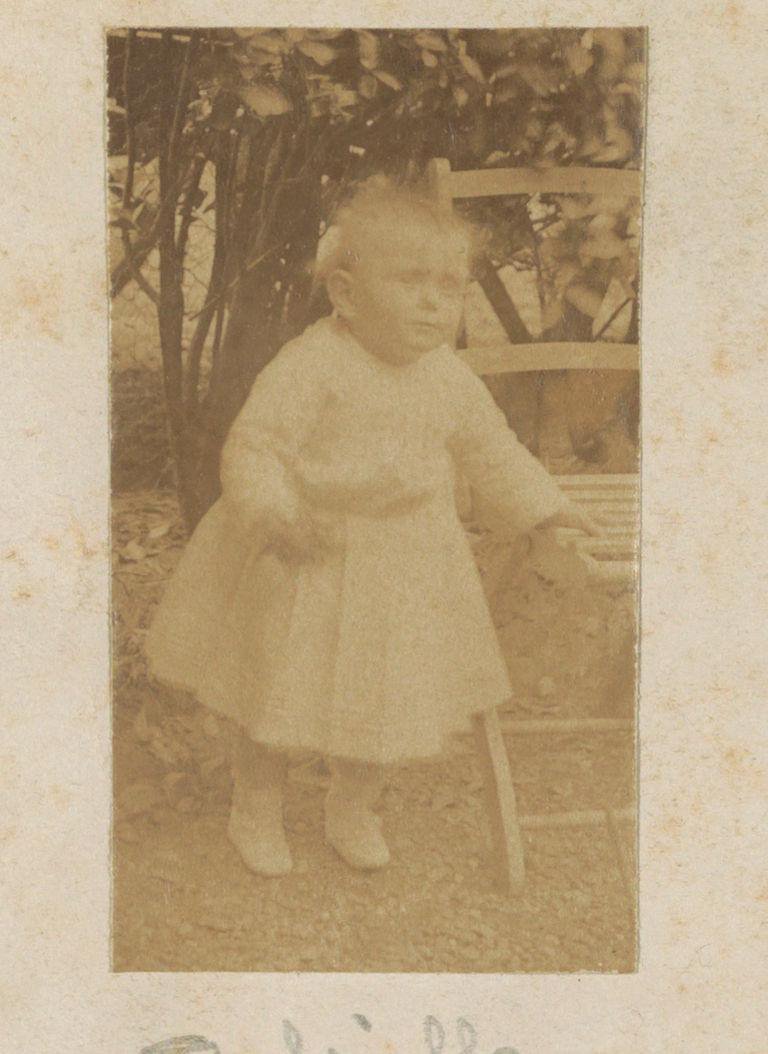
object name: photograph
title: Portret van een klein meisje, aangeduid als Gabrielle, staand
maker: Anonymous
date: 1883-1886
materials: photographic support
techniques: albumen print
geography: france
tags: tot, toddler ~ the ages of man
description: Onderdeel van Album van een Franse amateurfotograaf met opnames van familie, militairen, industrie, landschappen en bezienswaardigheden in Frankrijk.